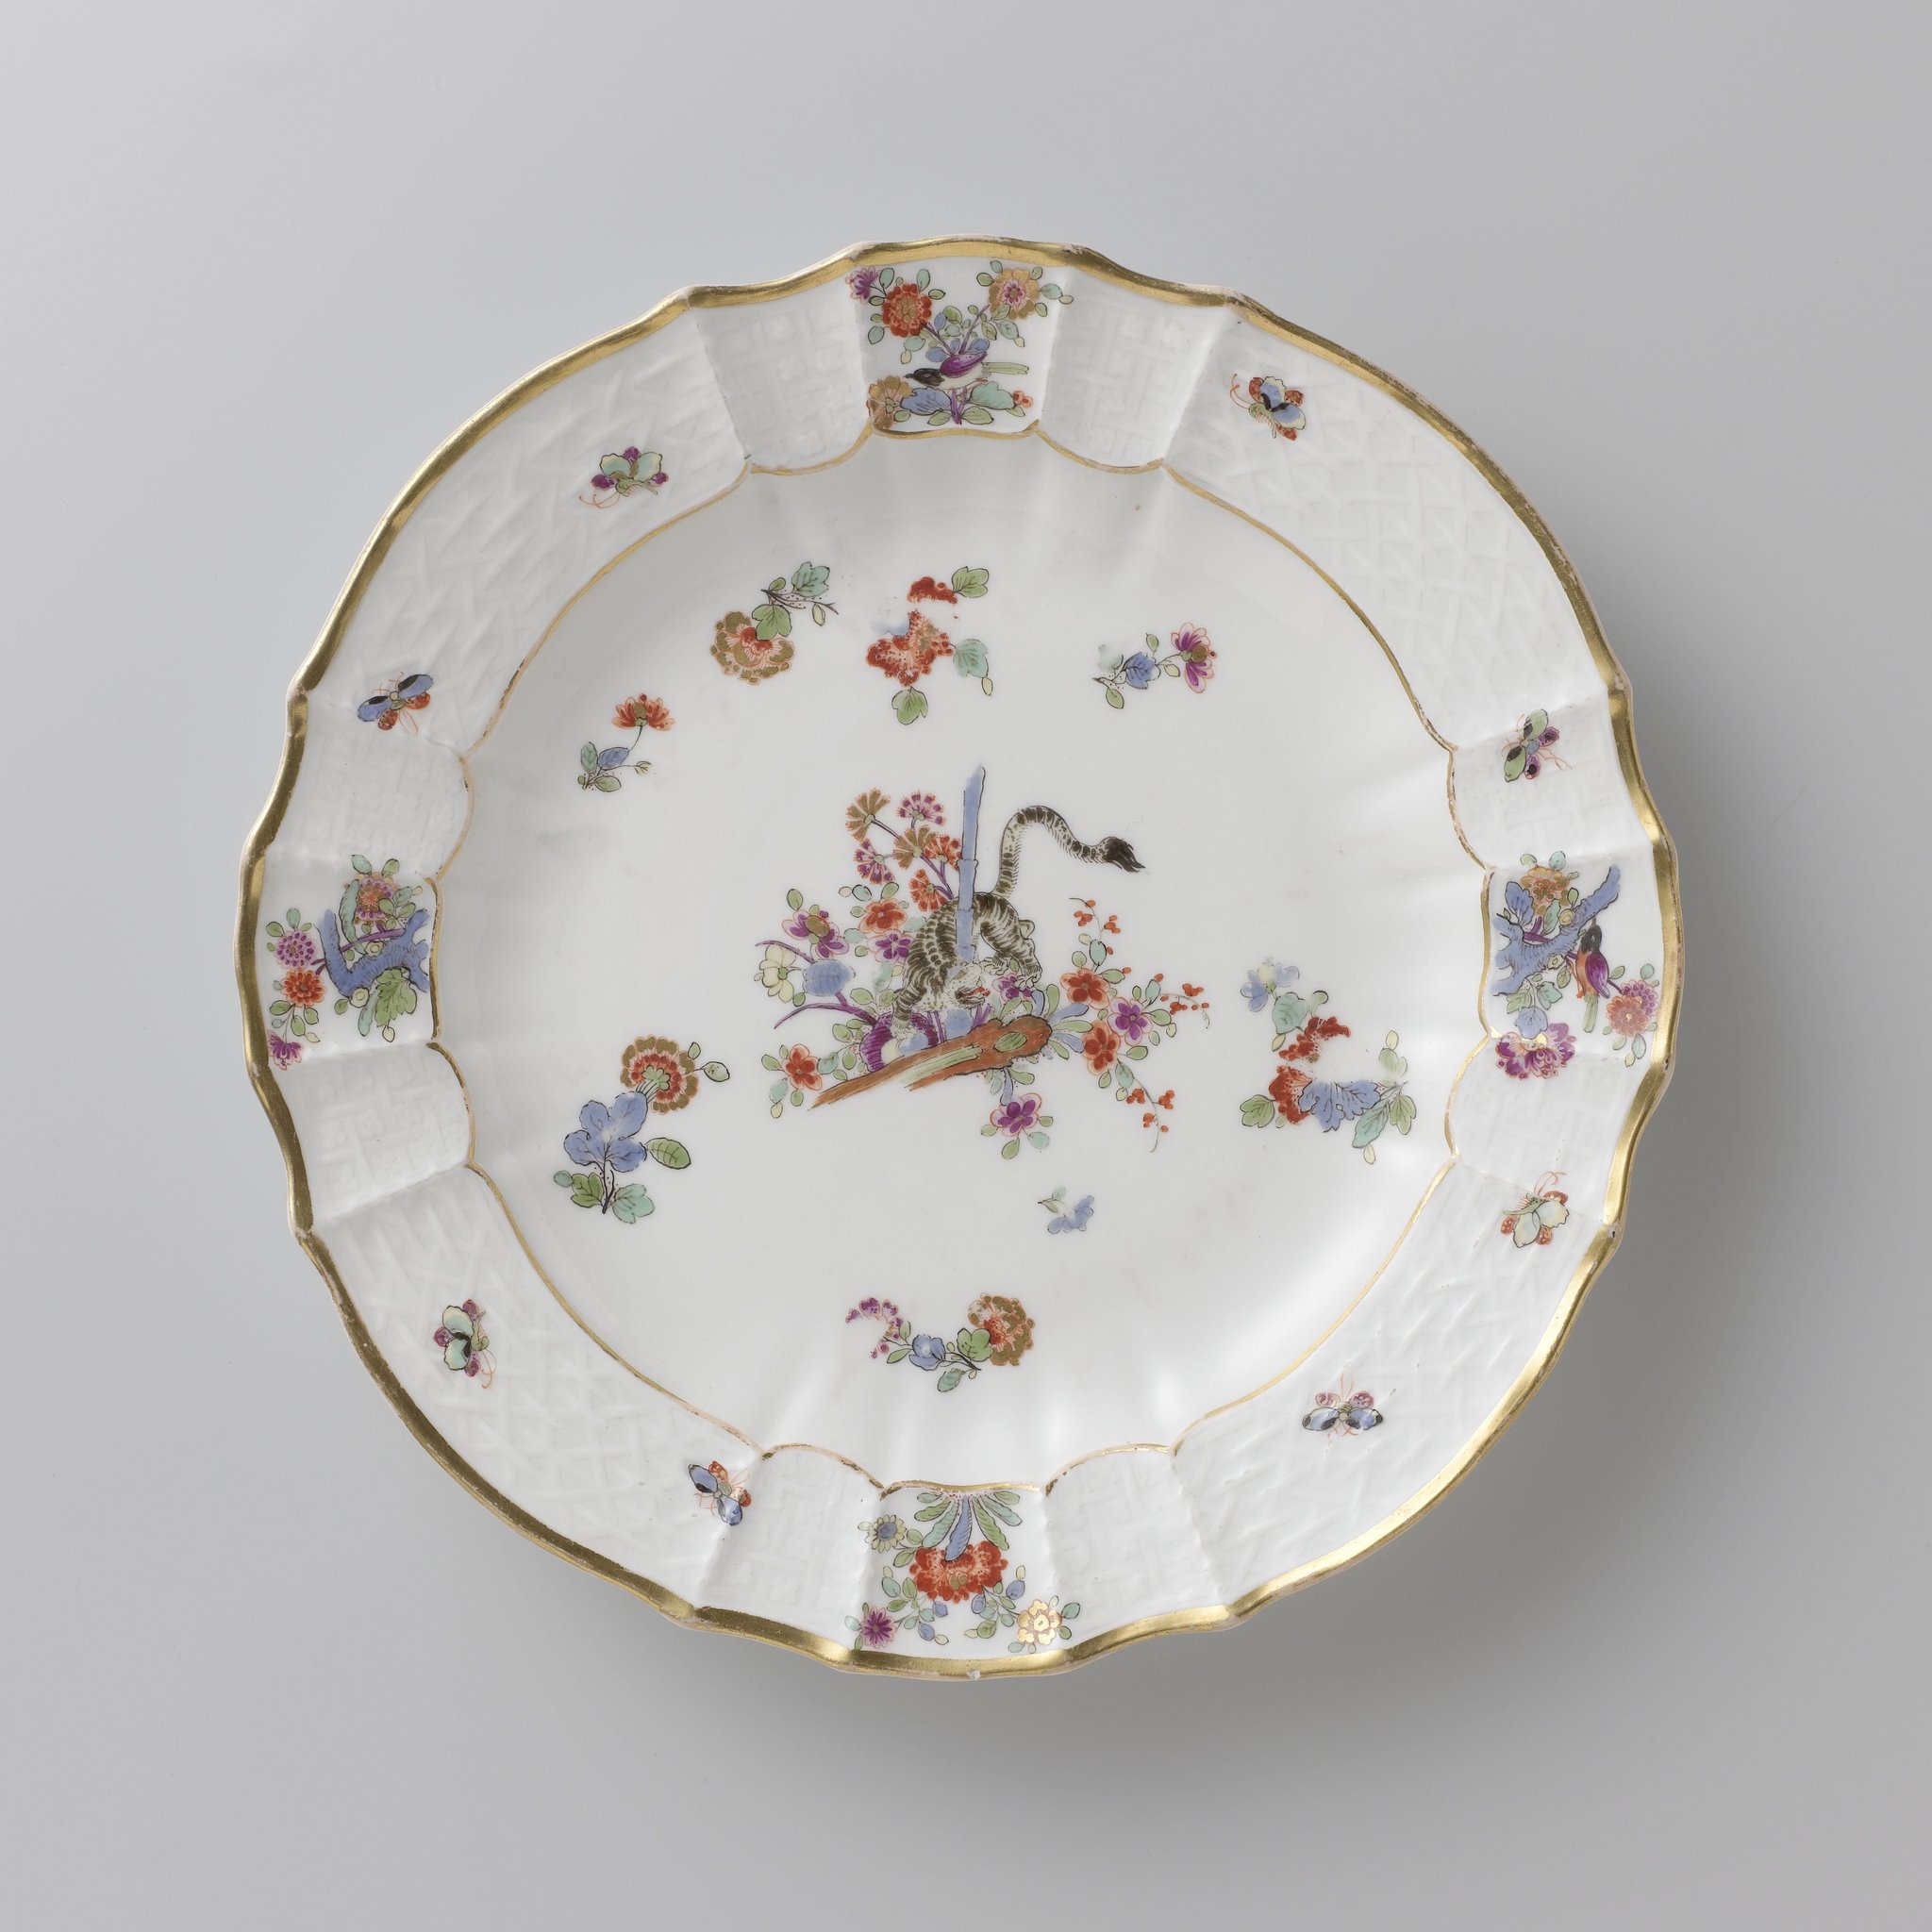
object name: plate dish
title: Rond bord, veelkleurig beschilderd met een Kakiemon-decor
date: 1740-1745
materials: porcelain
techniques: painted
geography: meissen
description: Rond bord van beschilderd porselein. Het bord is geribd en heeft een geschulpte rand. Het bord is beschilderd met een tijger die om een blauwe bamboestengel tussen bloemen is gedraaid, gestrooide Indianische Blumen, vlinders en takken waarop vogels. De rand is versierd met het 'Altbrandenstein'-patroon. Het bord is gemerkt.